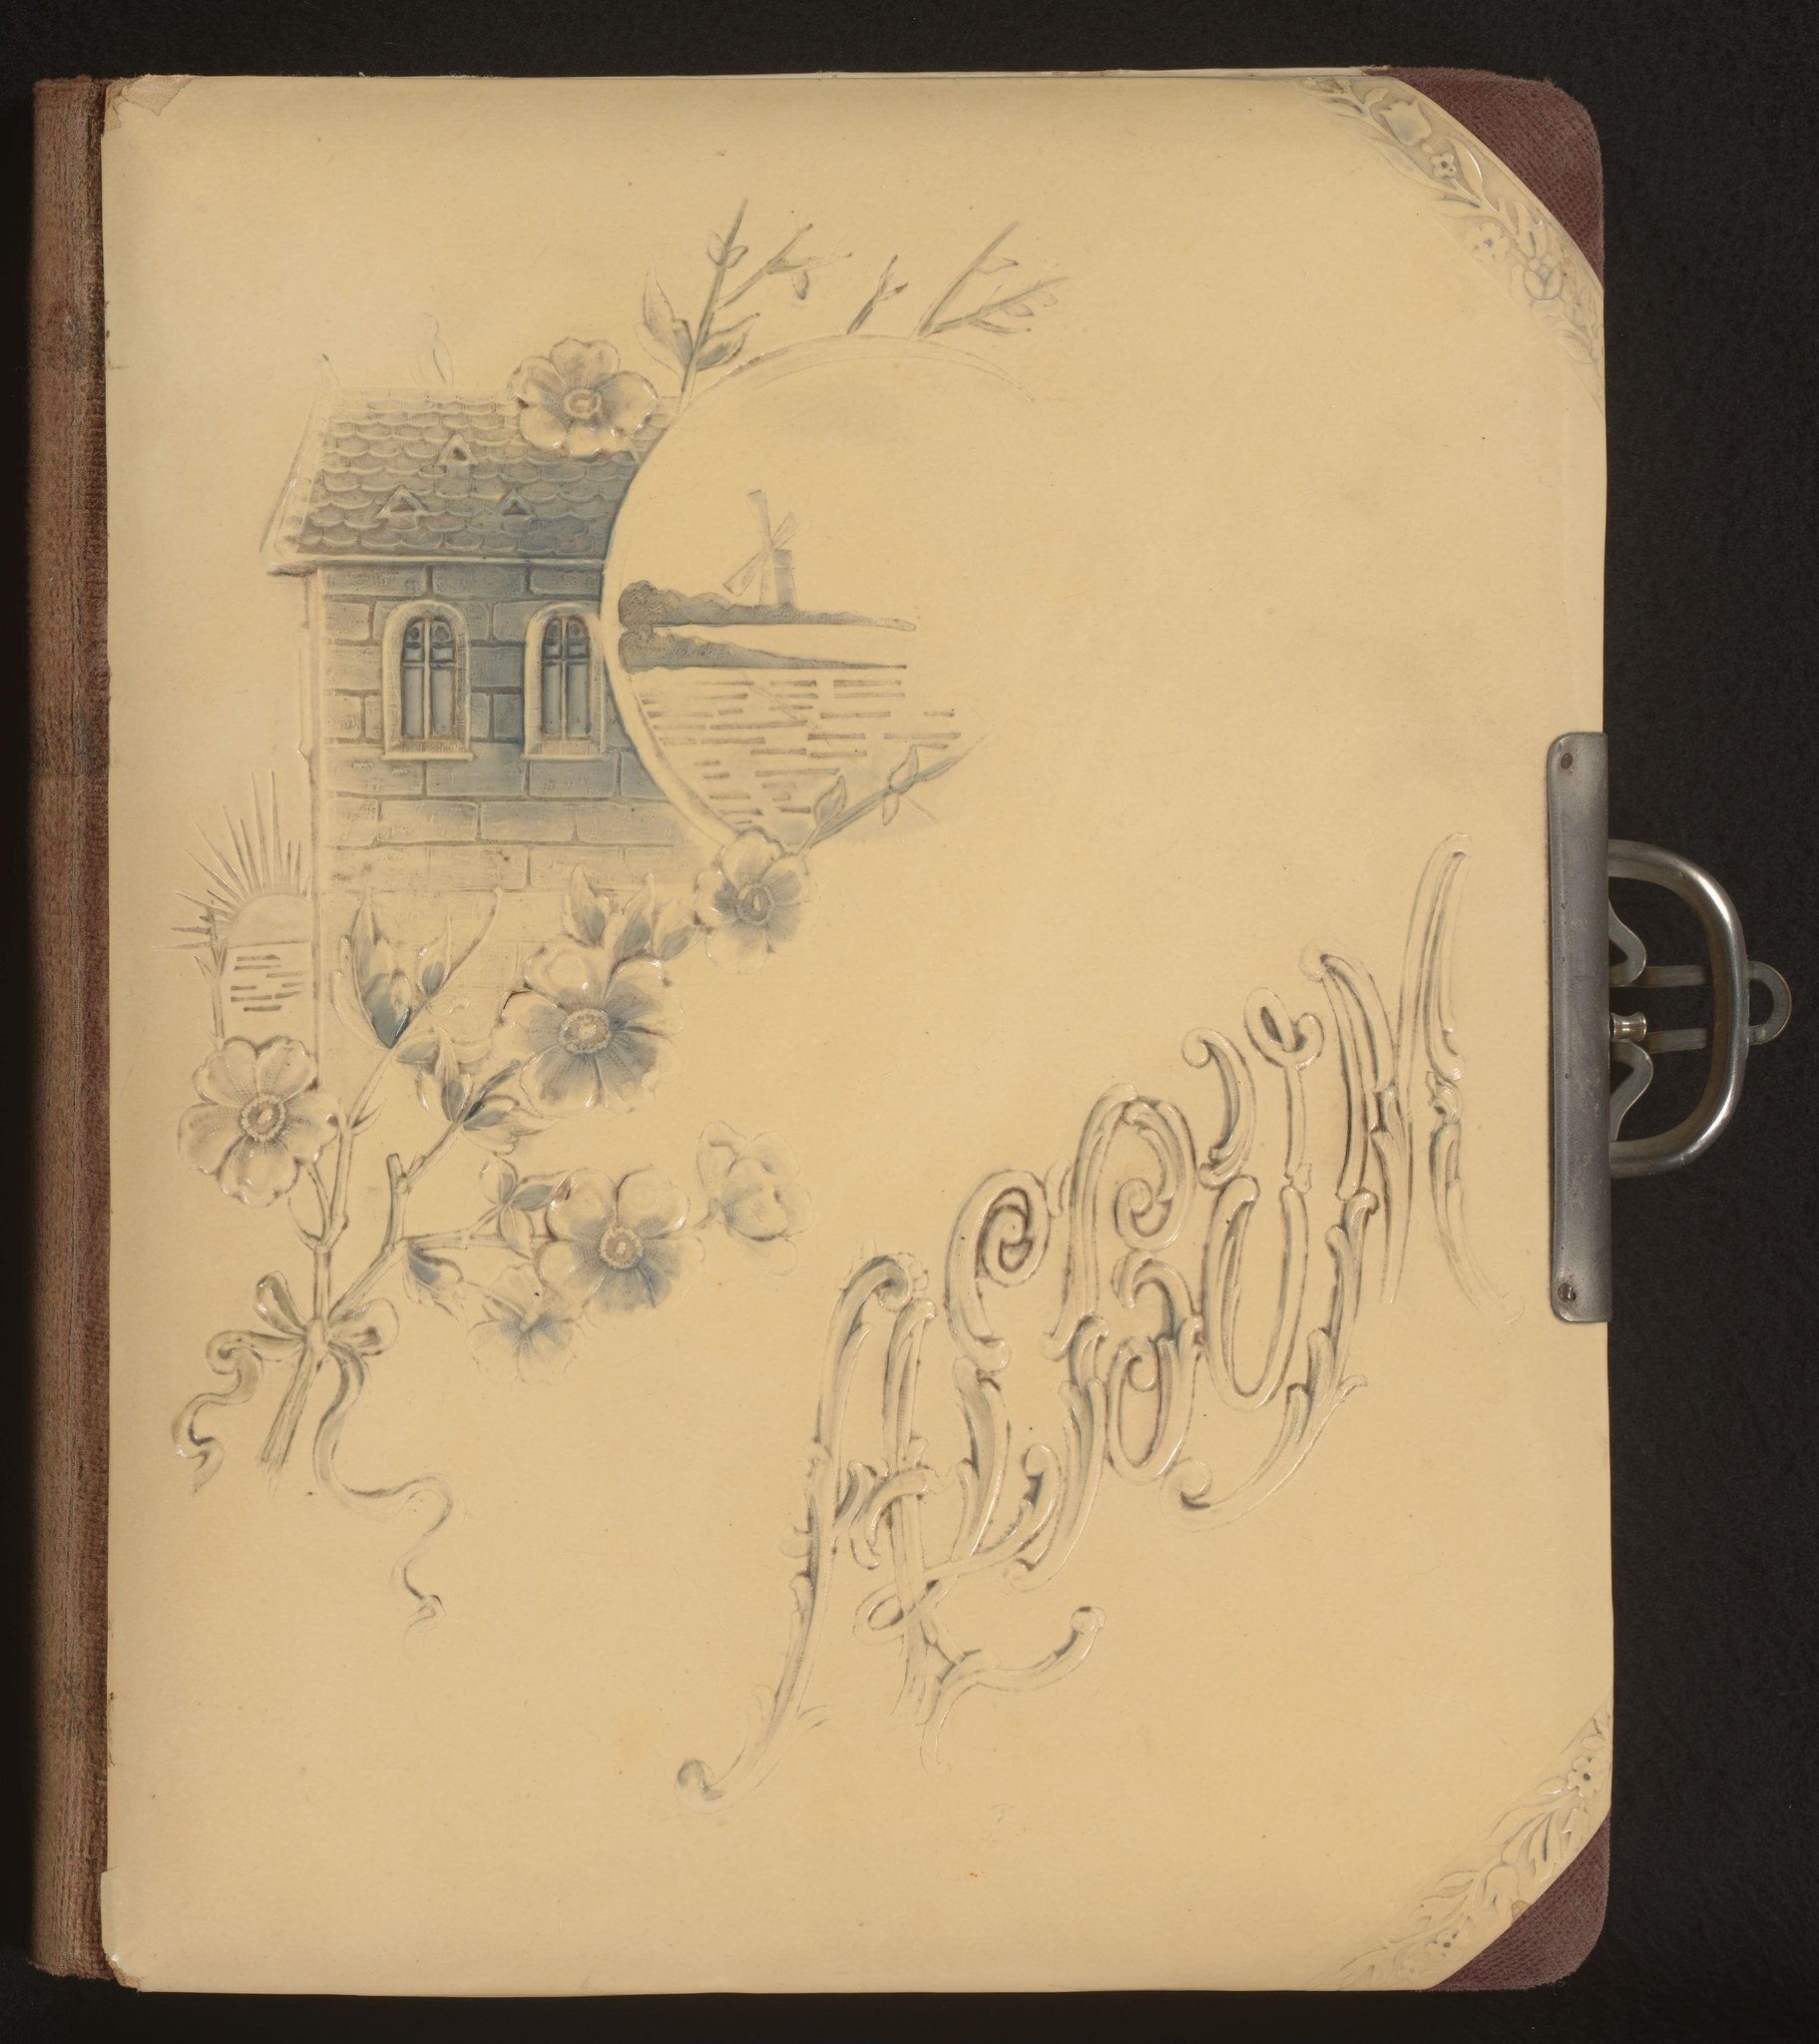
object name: photograph album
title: Album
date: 1880-1920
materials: cardboard, metal, paper, photographic support, textile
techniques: collodion silver print, color on snow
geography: netherlands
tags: historical persons - bb - woman, historical persons, girl (child between toddler and youth)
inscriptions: collector's mark: ‘DIENST/ VERSPREIDE/ RIJKSKOLLEKTIES/ (...) A 700’, number: ‘45,-’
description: Fotoalbum met 24 pagina's met passe-partouts voor kabinetfoto's en cartes-de-visite, waarvan twee passe-partouts zijn gevuld met een kabinetfoto. Afgebeeld zijn een portret van een man en een portret van een meisje. Het portret van de man is gemaakt door de fotograaf P.D. van Rhijn te Amsterdam. Het portret van het meisje is gemaakt door een anonieme fotograaf.